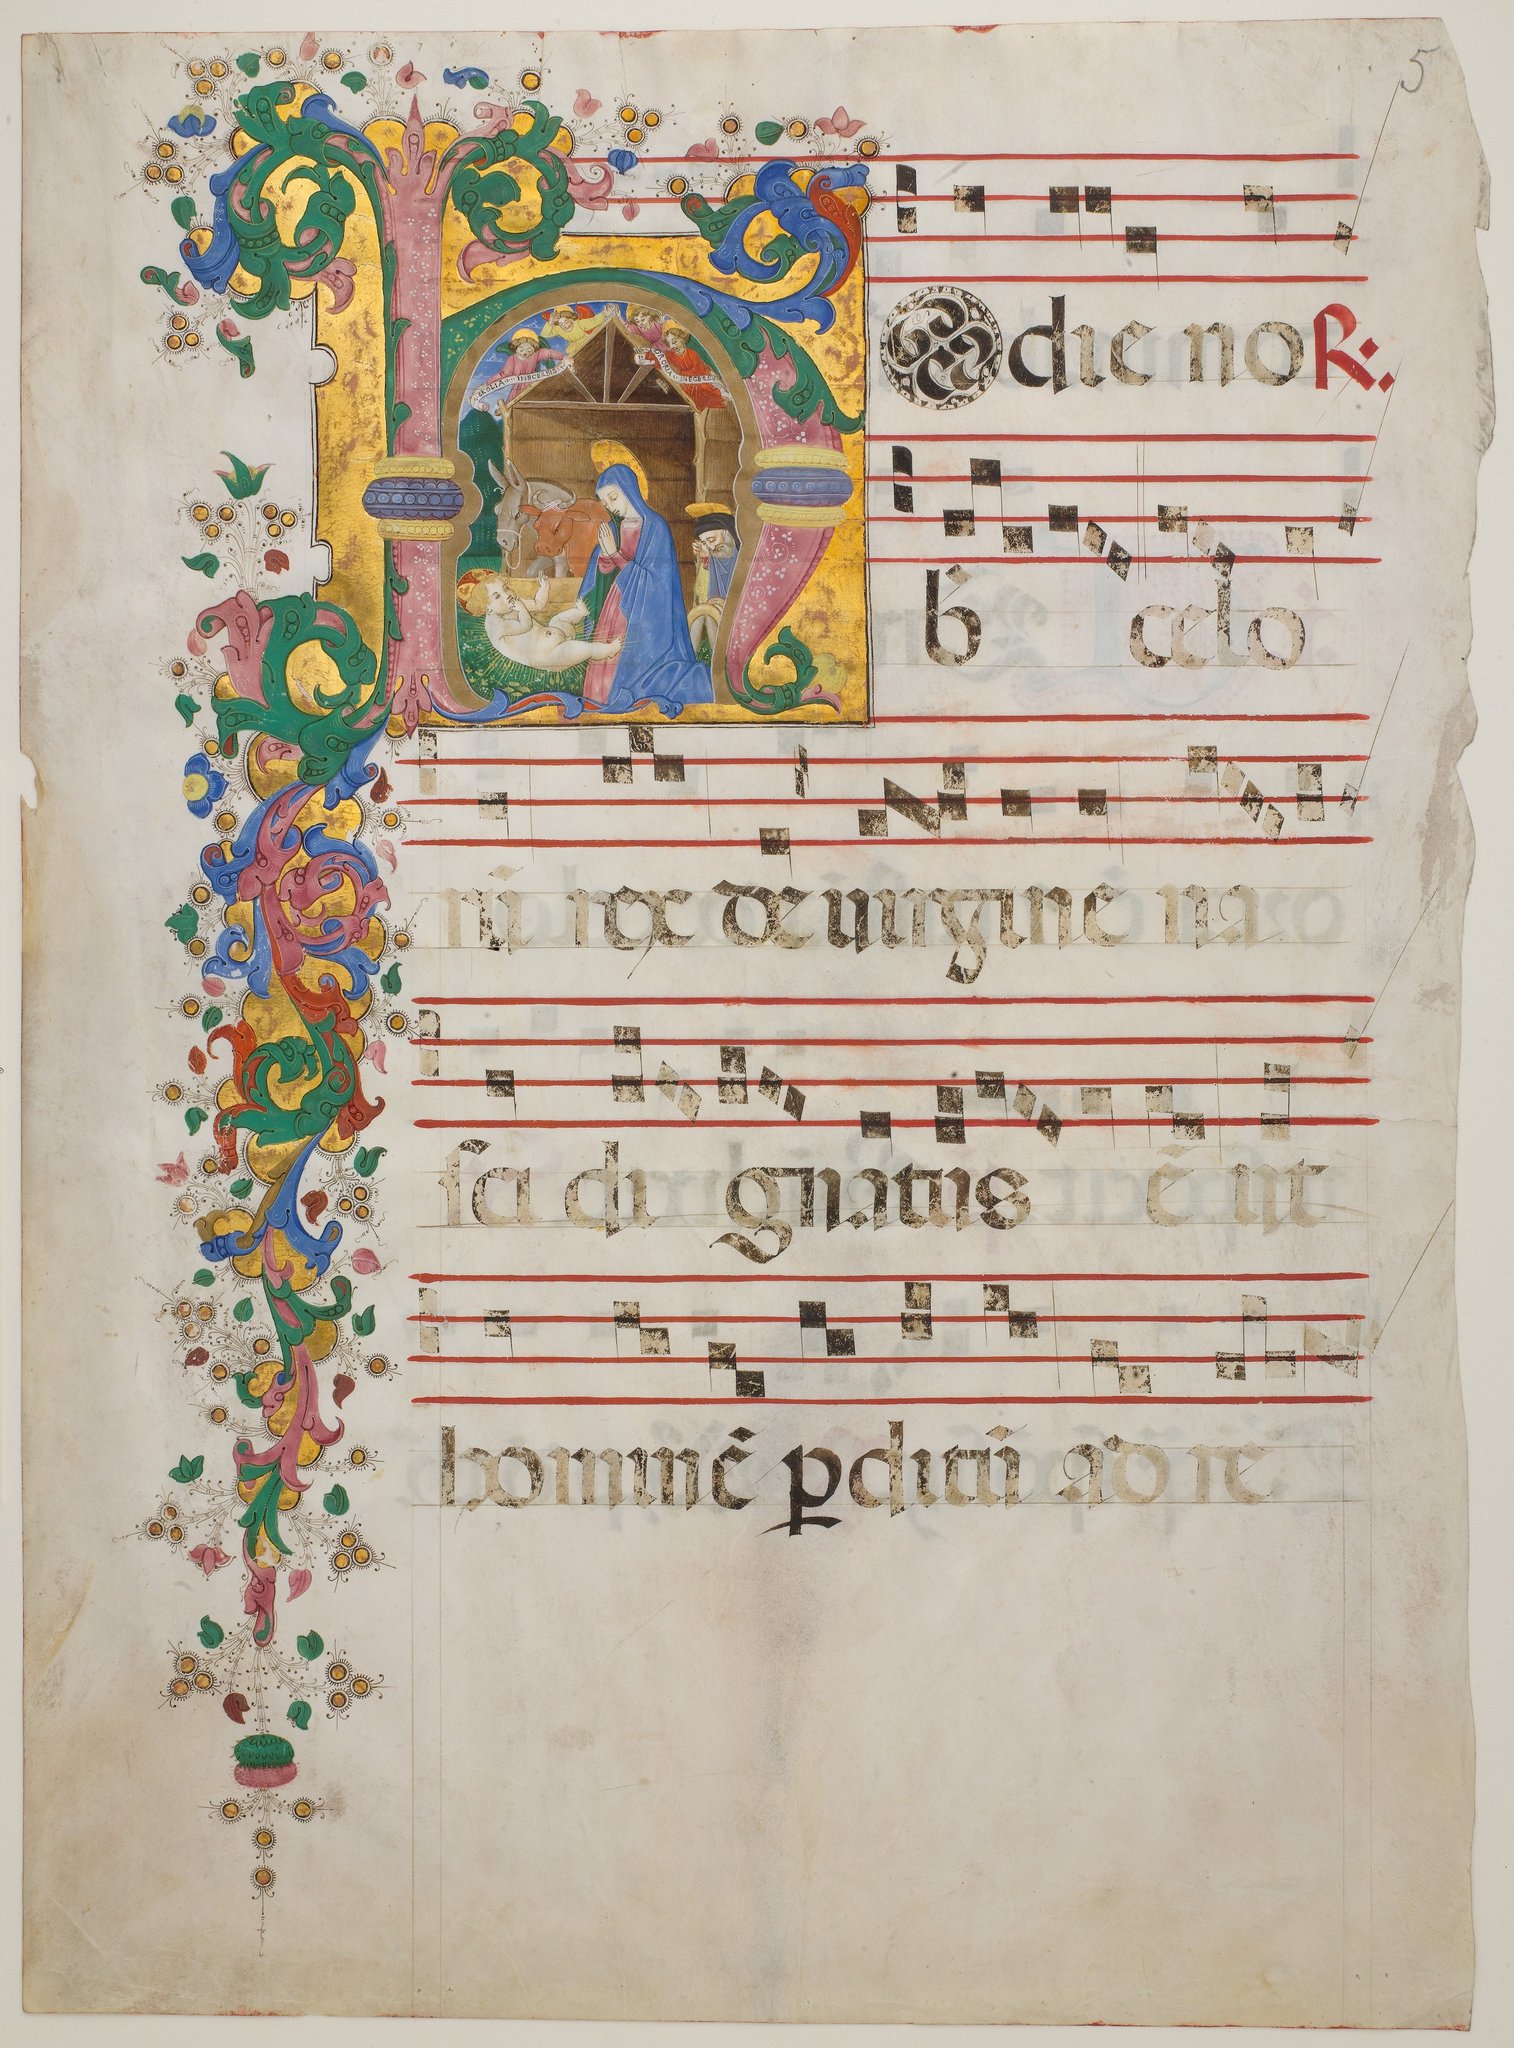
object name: antiphonary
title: Manuscript Leaf with the Nativity in an Initial H, from an Antiphonary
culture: italian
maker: master of the riccardiana lactantius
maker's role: artist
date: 1451-1500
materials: gold, ink, parchment, paint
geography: italy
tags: donkeys,virgin mary,jesus,nativity,ox